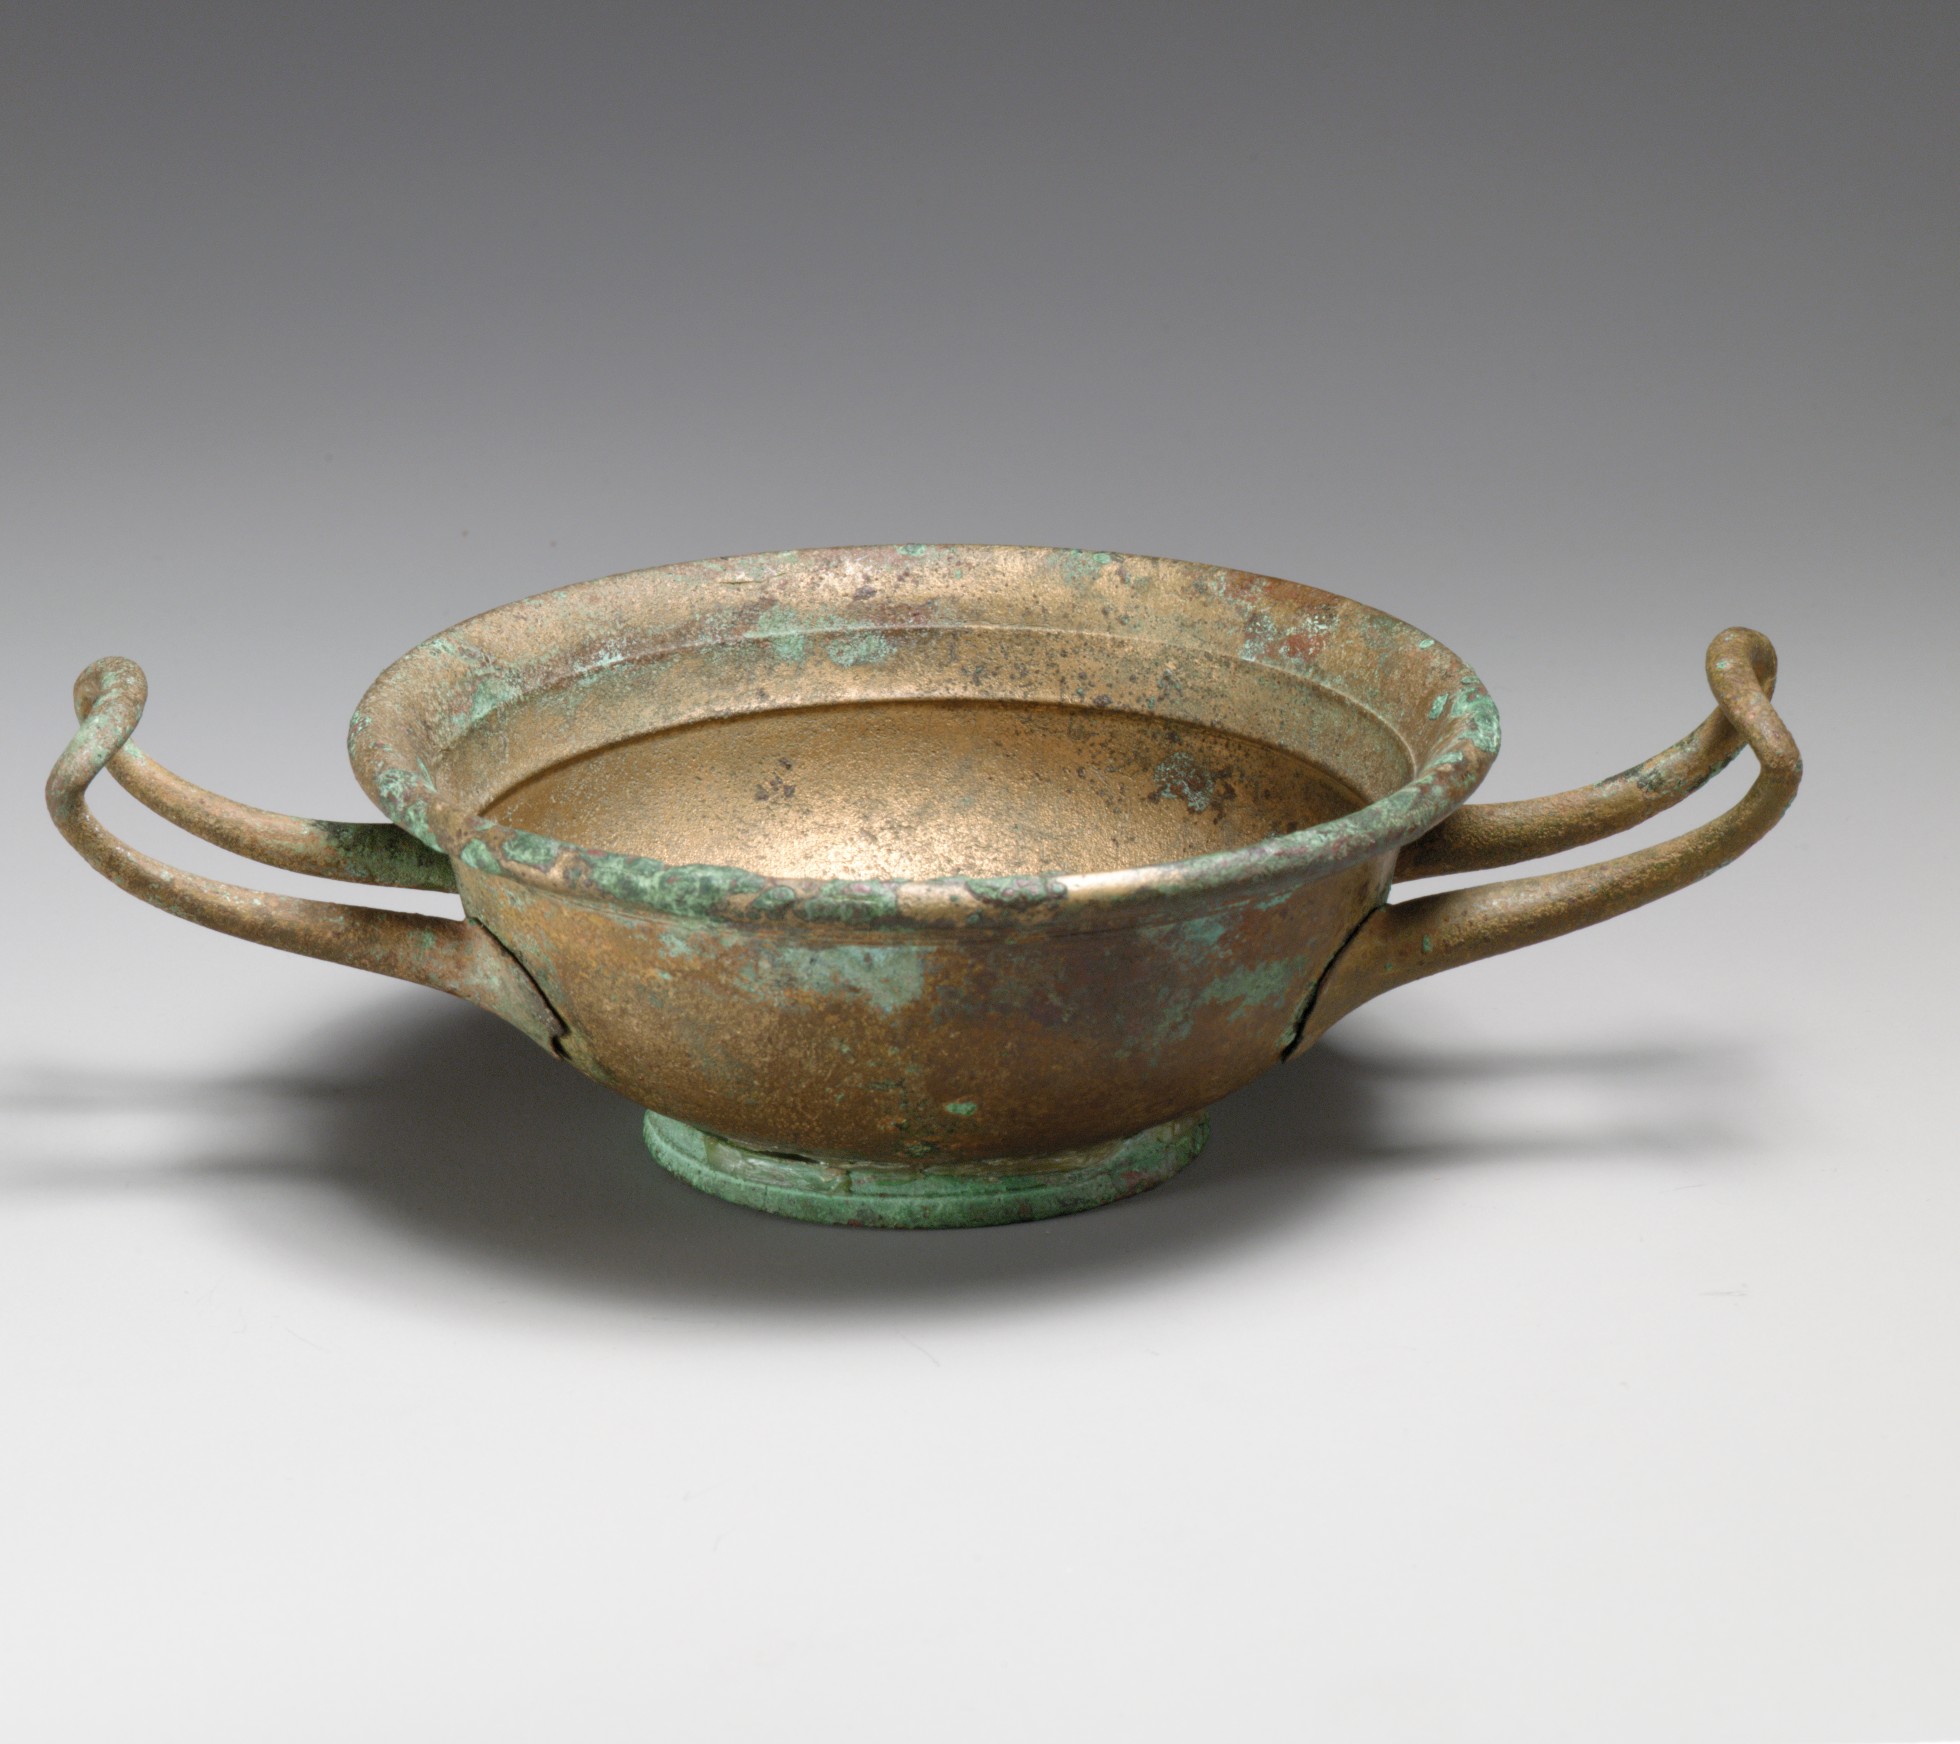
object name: kylix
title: Bronze kylix (drinking cup)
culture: greek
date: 400-201 BCE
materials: bronze